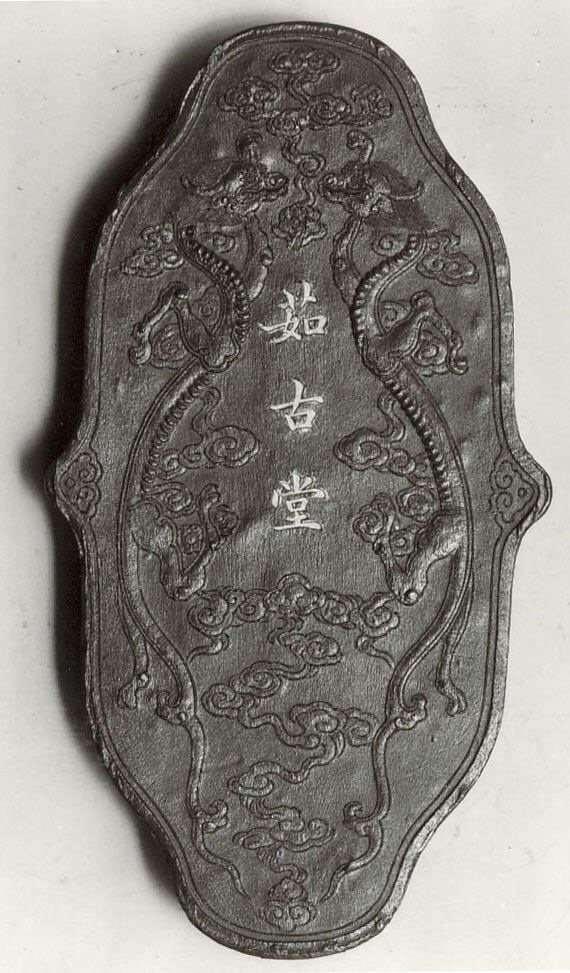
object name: ink tablet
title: Feasting on Antiquities Hall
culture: chinese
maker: jian guzhai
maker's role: artist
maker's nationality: chinese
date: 1867-1933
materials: ink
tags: dragons